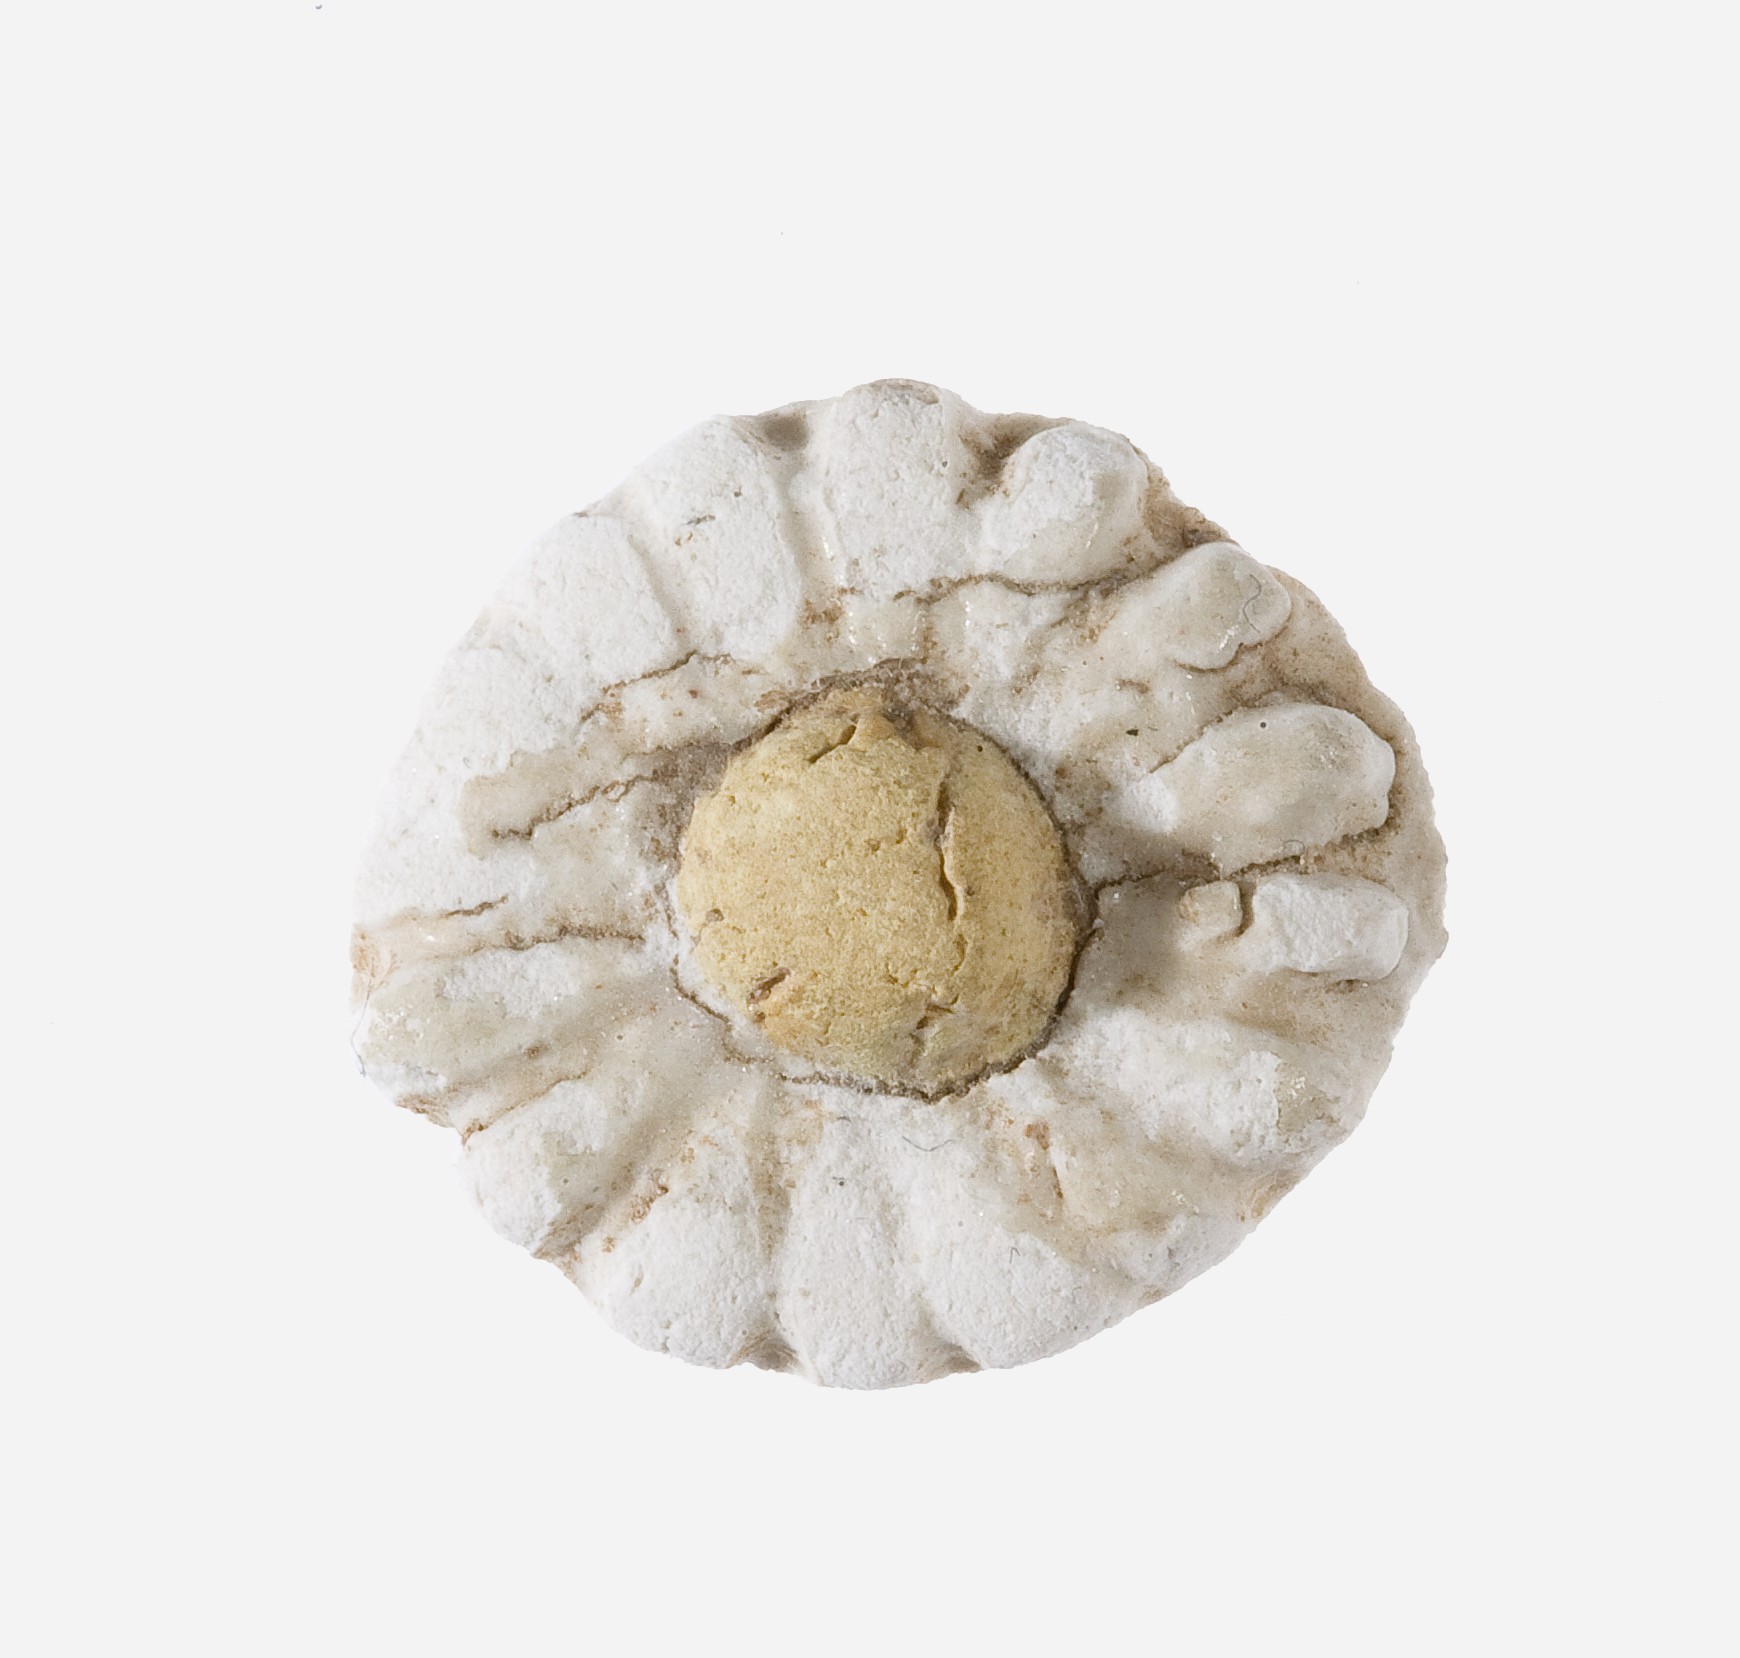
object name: bead, daisy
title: Daisy Bead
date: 1390-1352 BCE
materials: faience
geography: egypt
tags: daisies